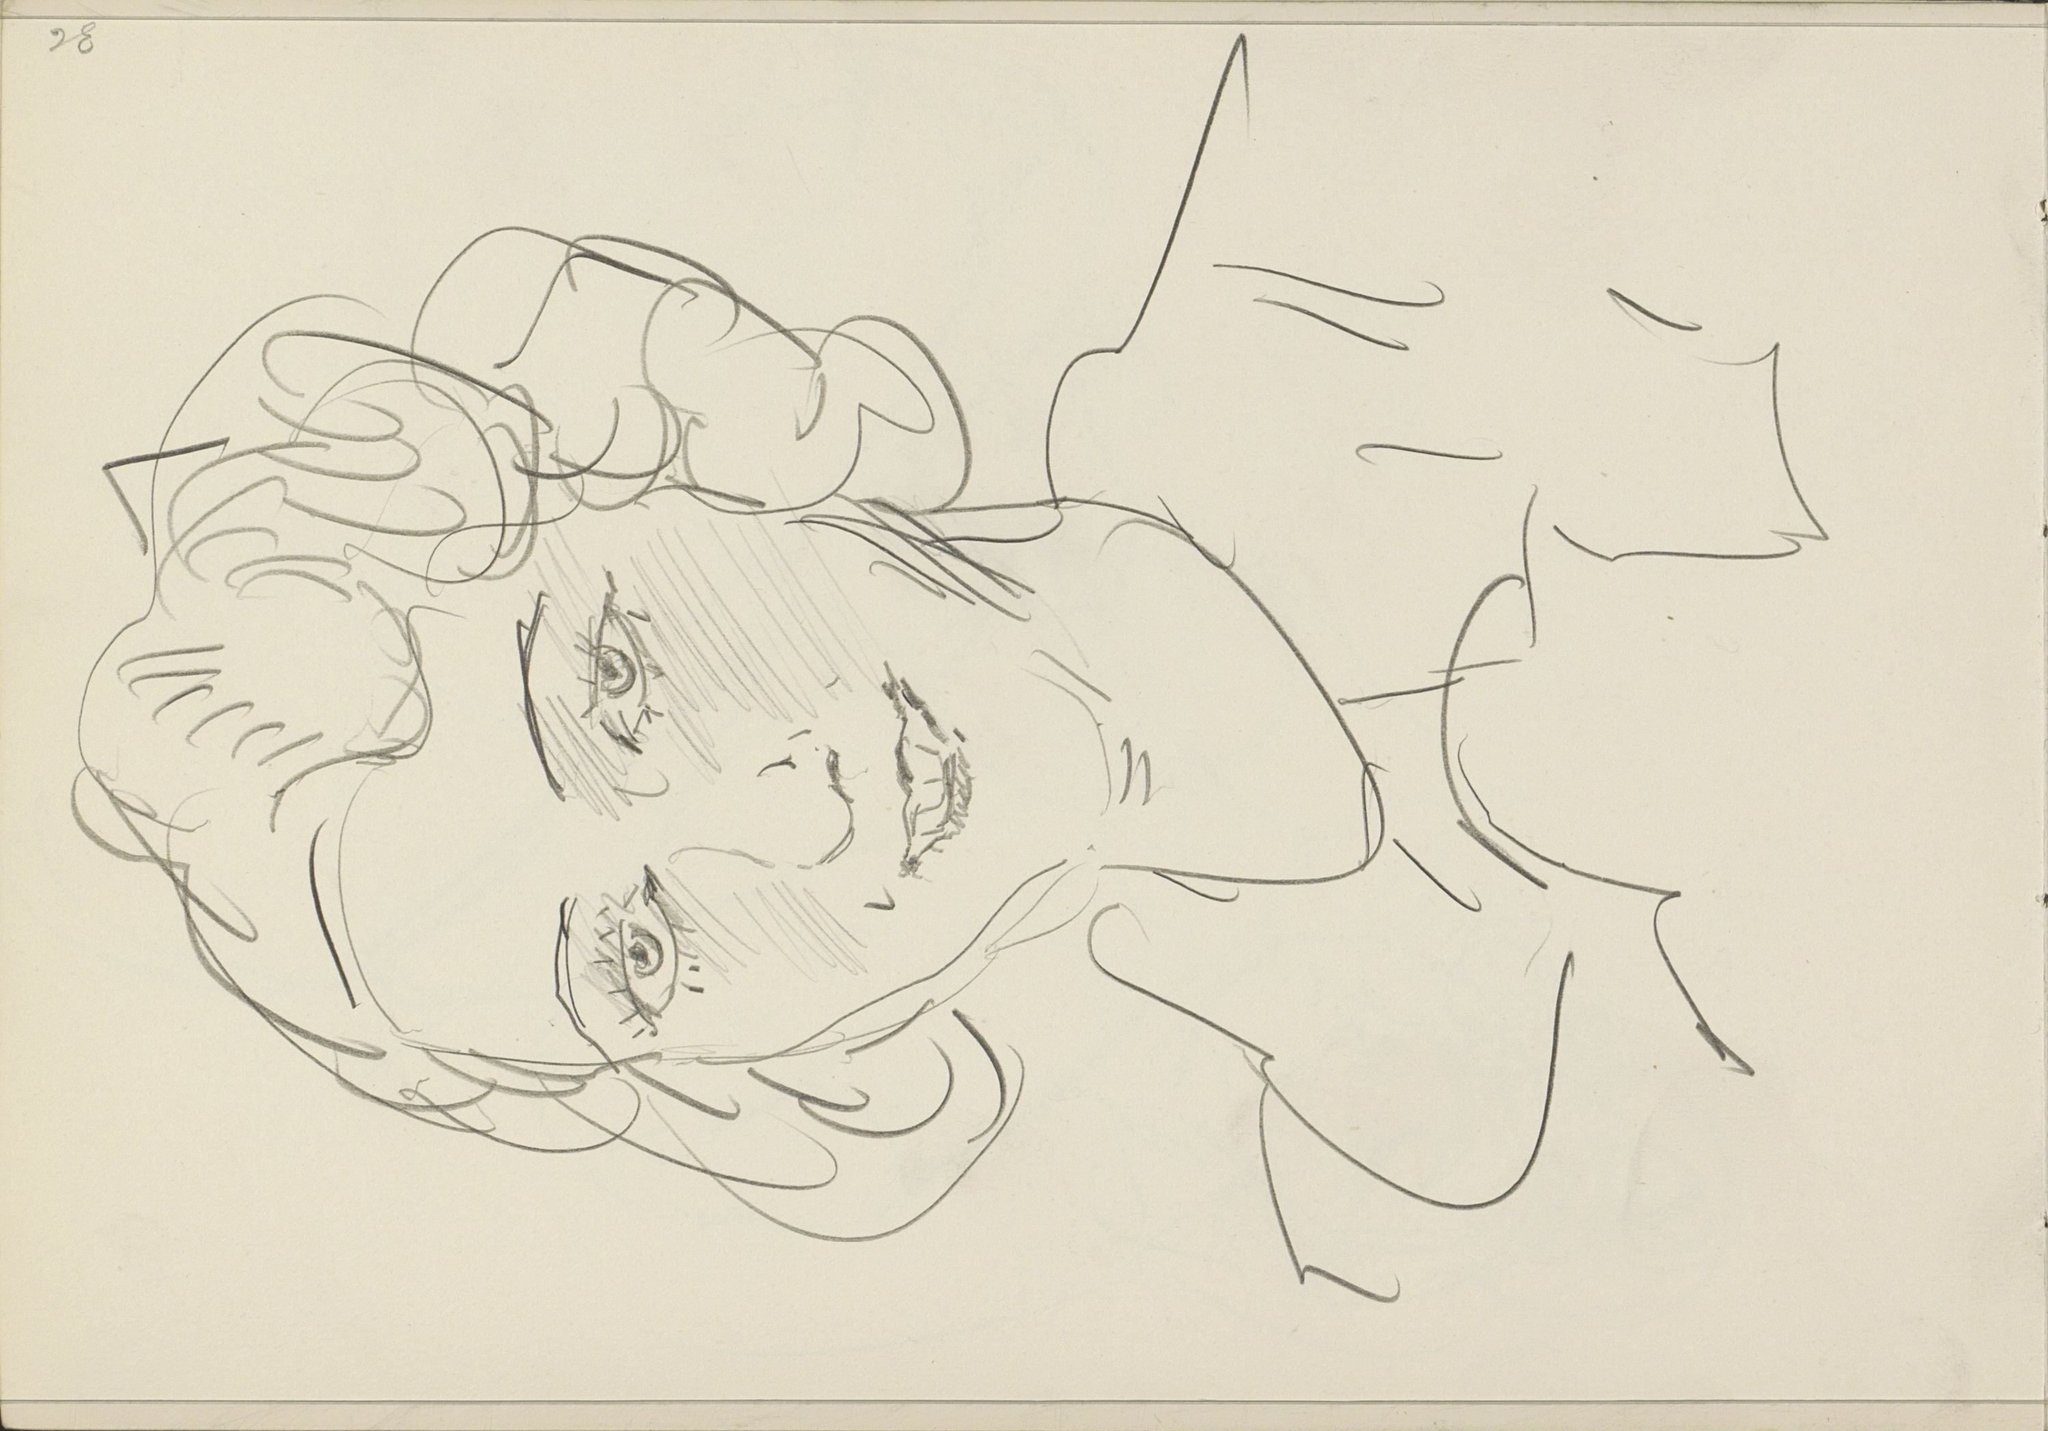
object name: sketchbook leaf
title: Vrouwenhoofd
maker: isaac israels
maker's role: draughtsman, painter, print maker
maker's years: 1865-1934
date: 1915-1934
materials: paper, pencil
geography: the hague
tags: head (human) - aa - female human figure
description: Blad 12 verso uit schetsboek XXV met 23 bladen.